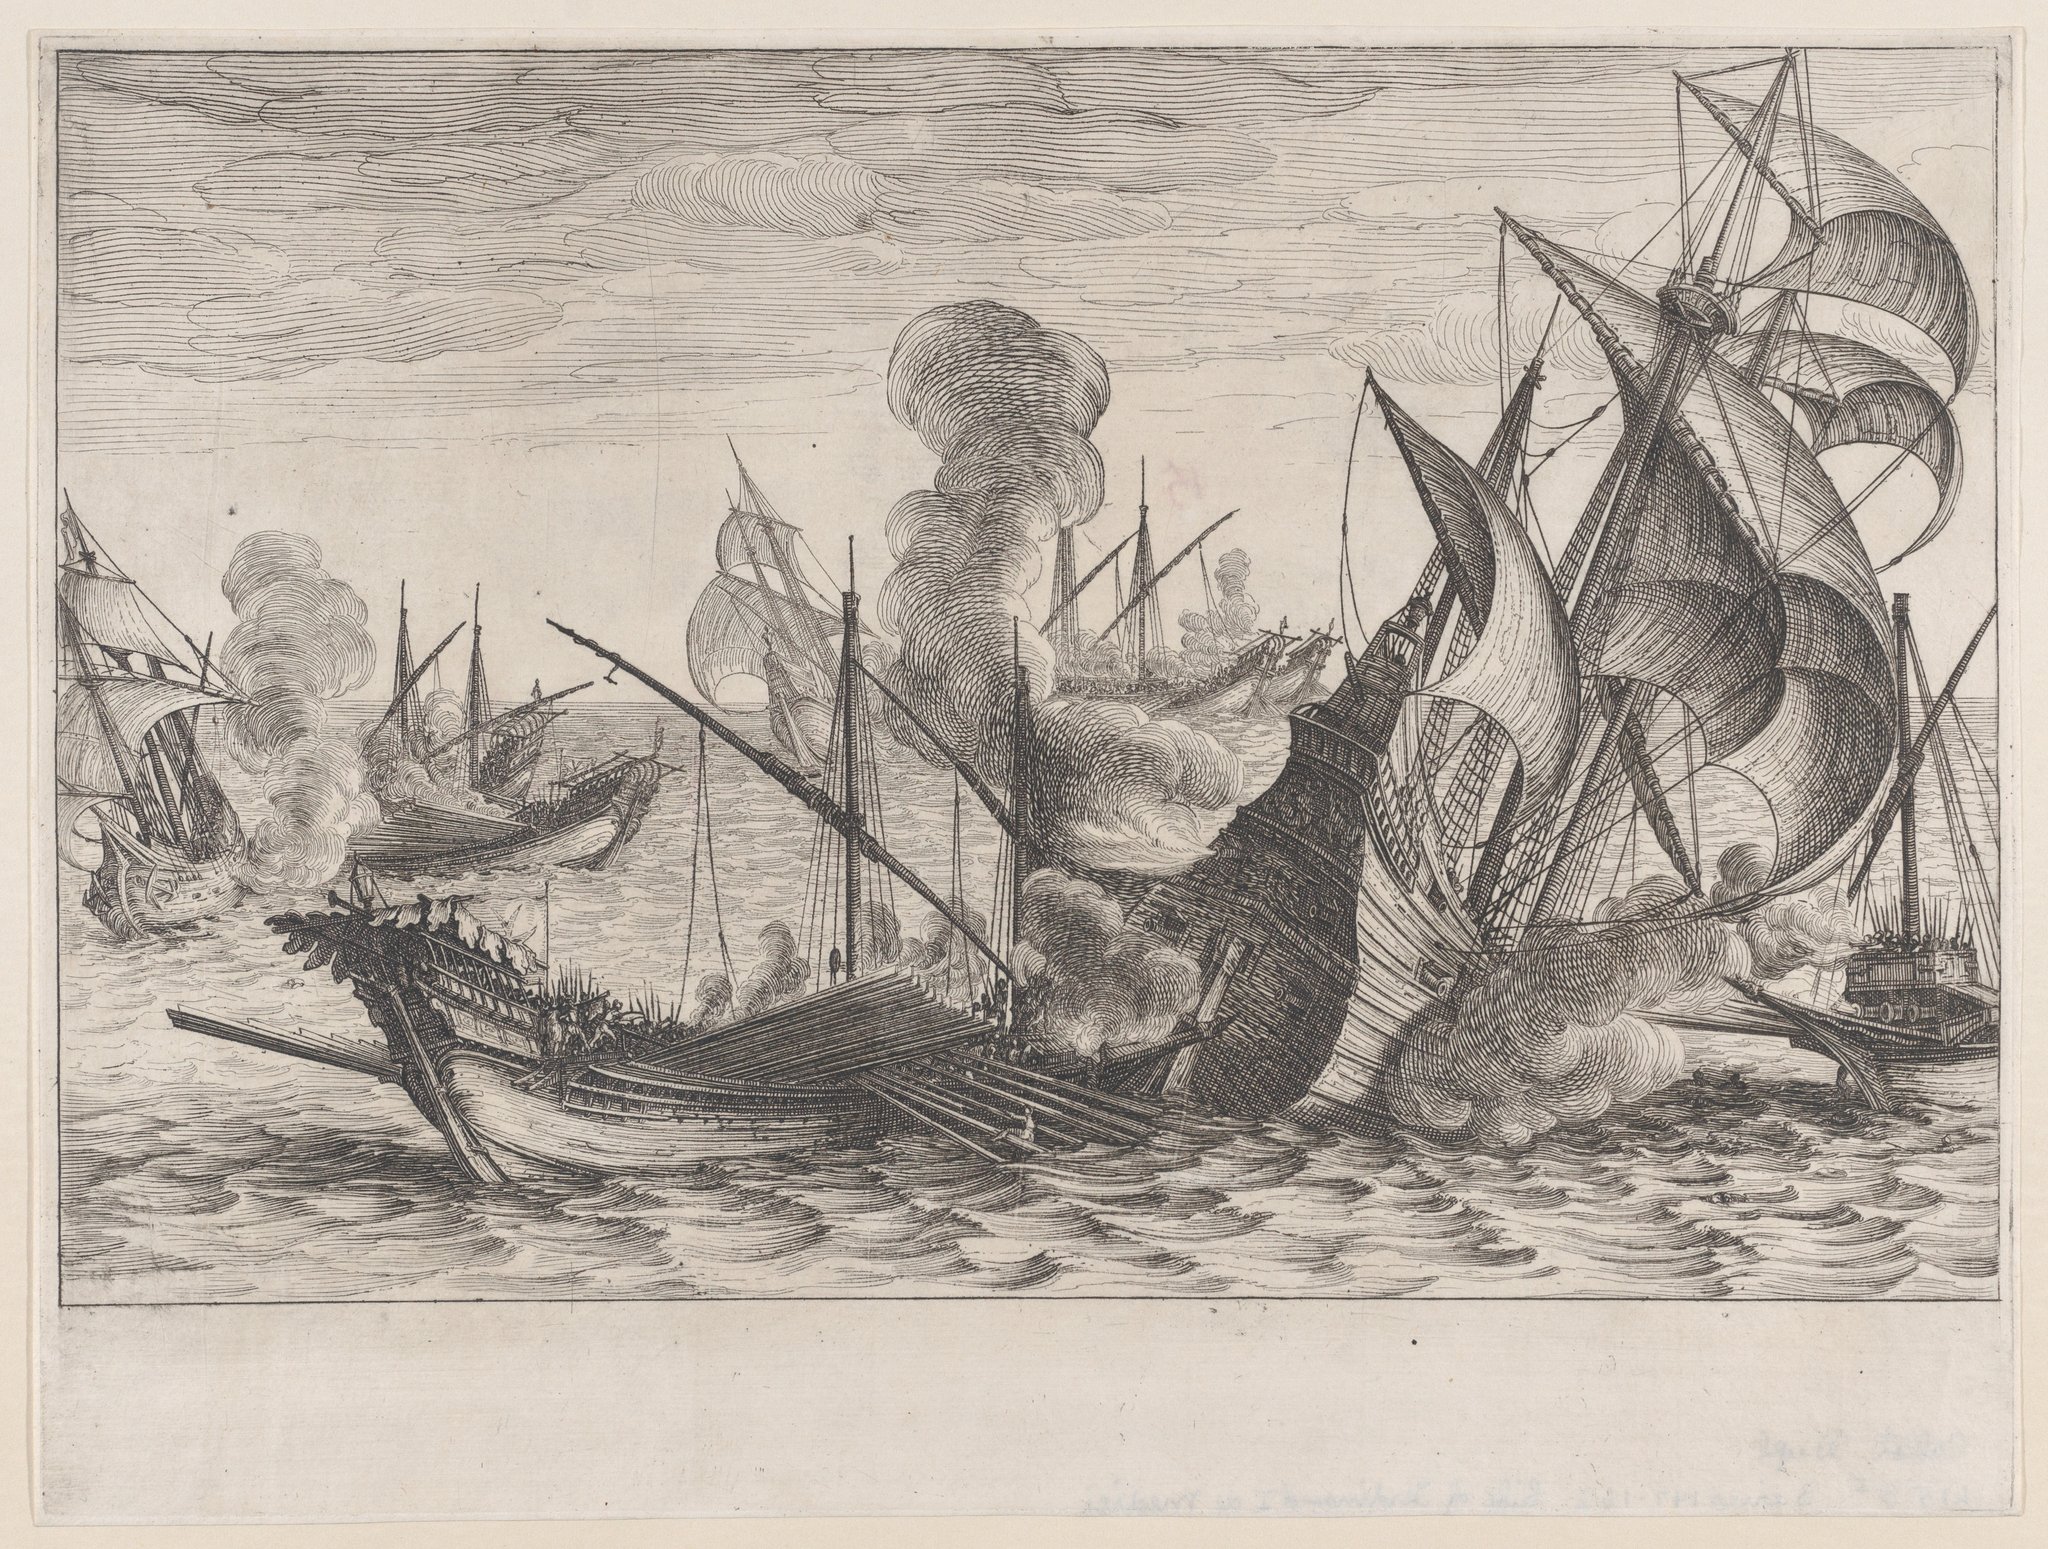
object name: print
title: 2e Combat Naval (Second Naval Battle), from La Vie de Ferdinand Ier de Médicis série appelée aussi Les Batailles des Médicis (The Life of Ferdinand I de'Medici also called The Medici Battles)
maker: jacques callot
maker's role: artist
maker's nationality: french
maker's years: 1592-1635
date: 1614-1620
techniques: etching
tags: battles,ships